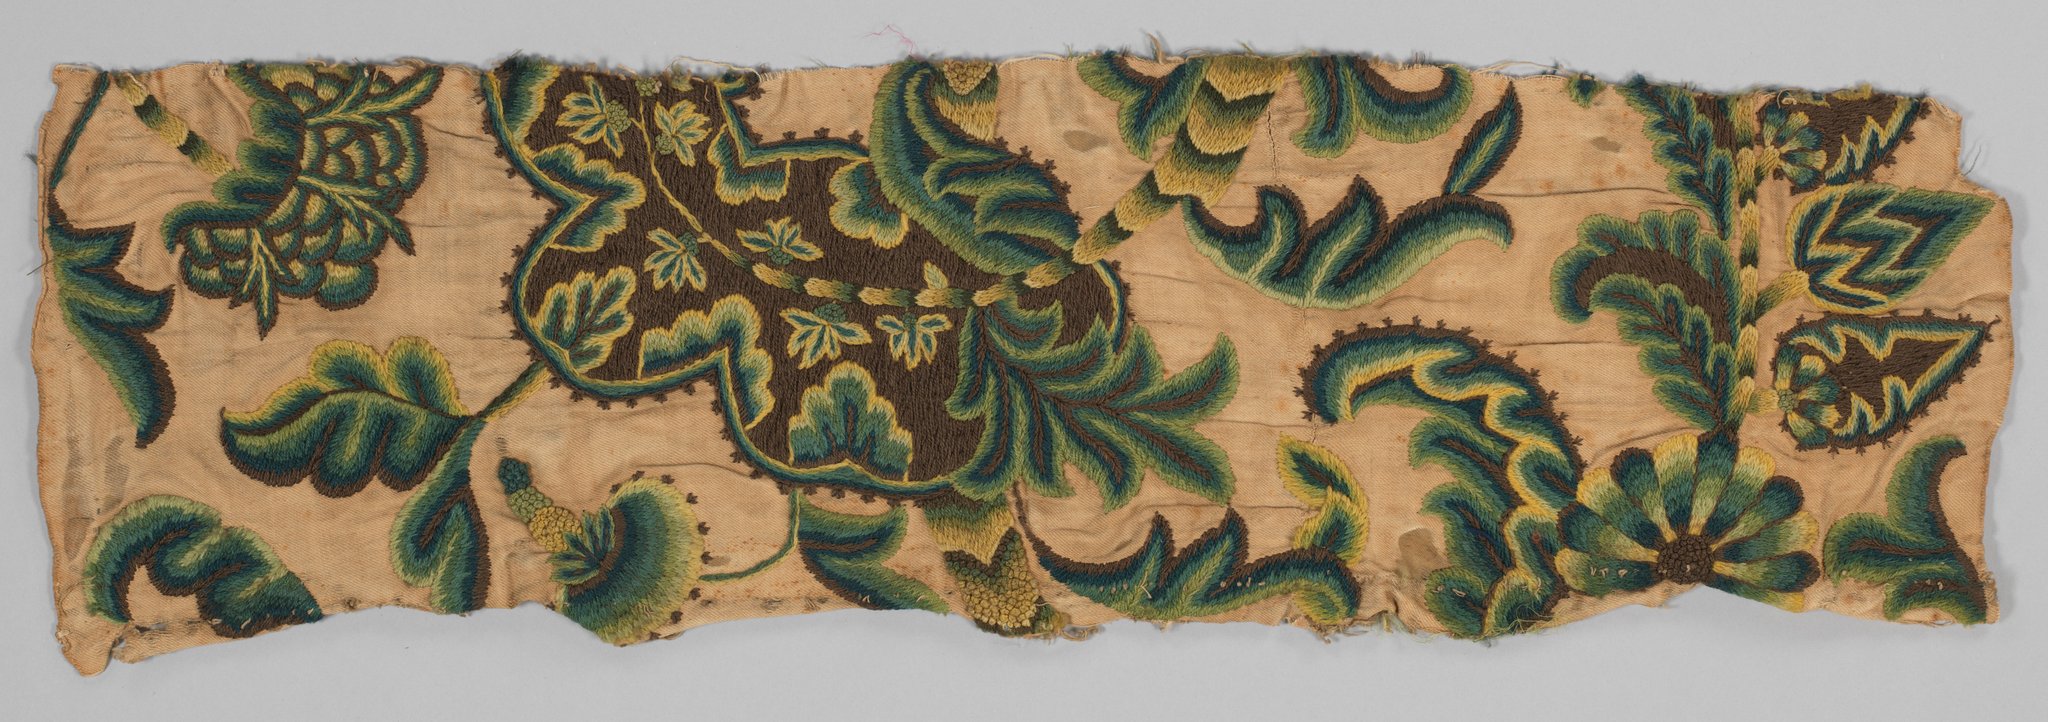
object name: piece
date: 1701-1800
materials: cotton, wool